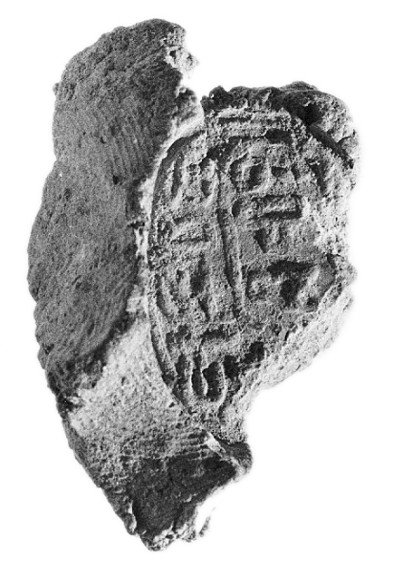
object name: sealing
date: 1981-1640 BCE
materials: mud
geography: egypt